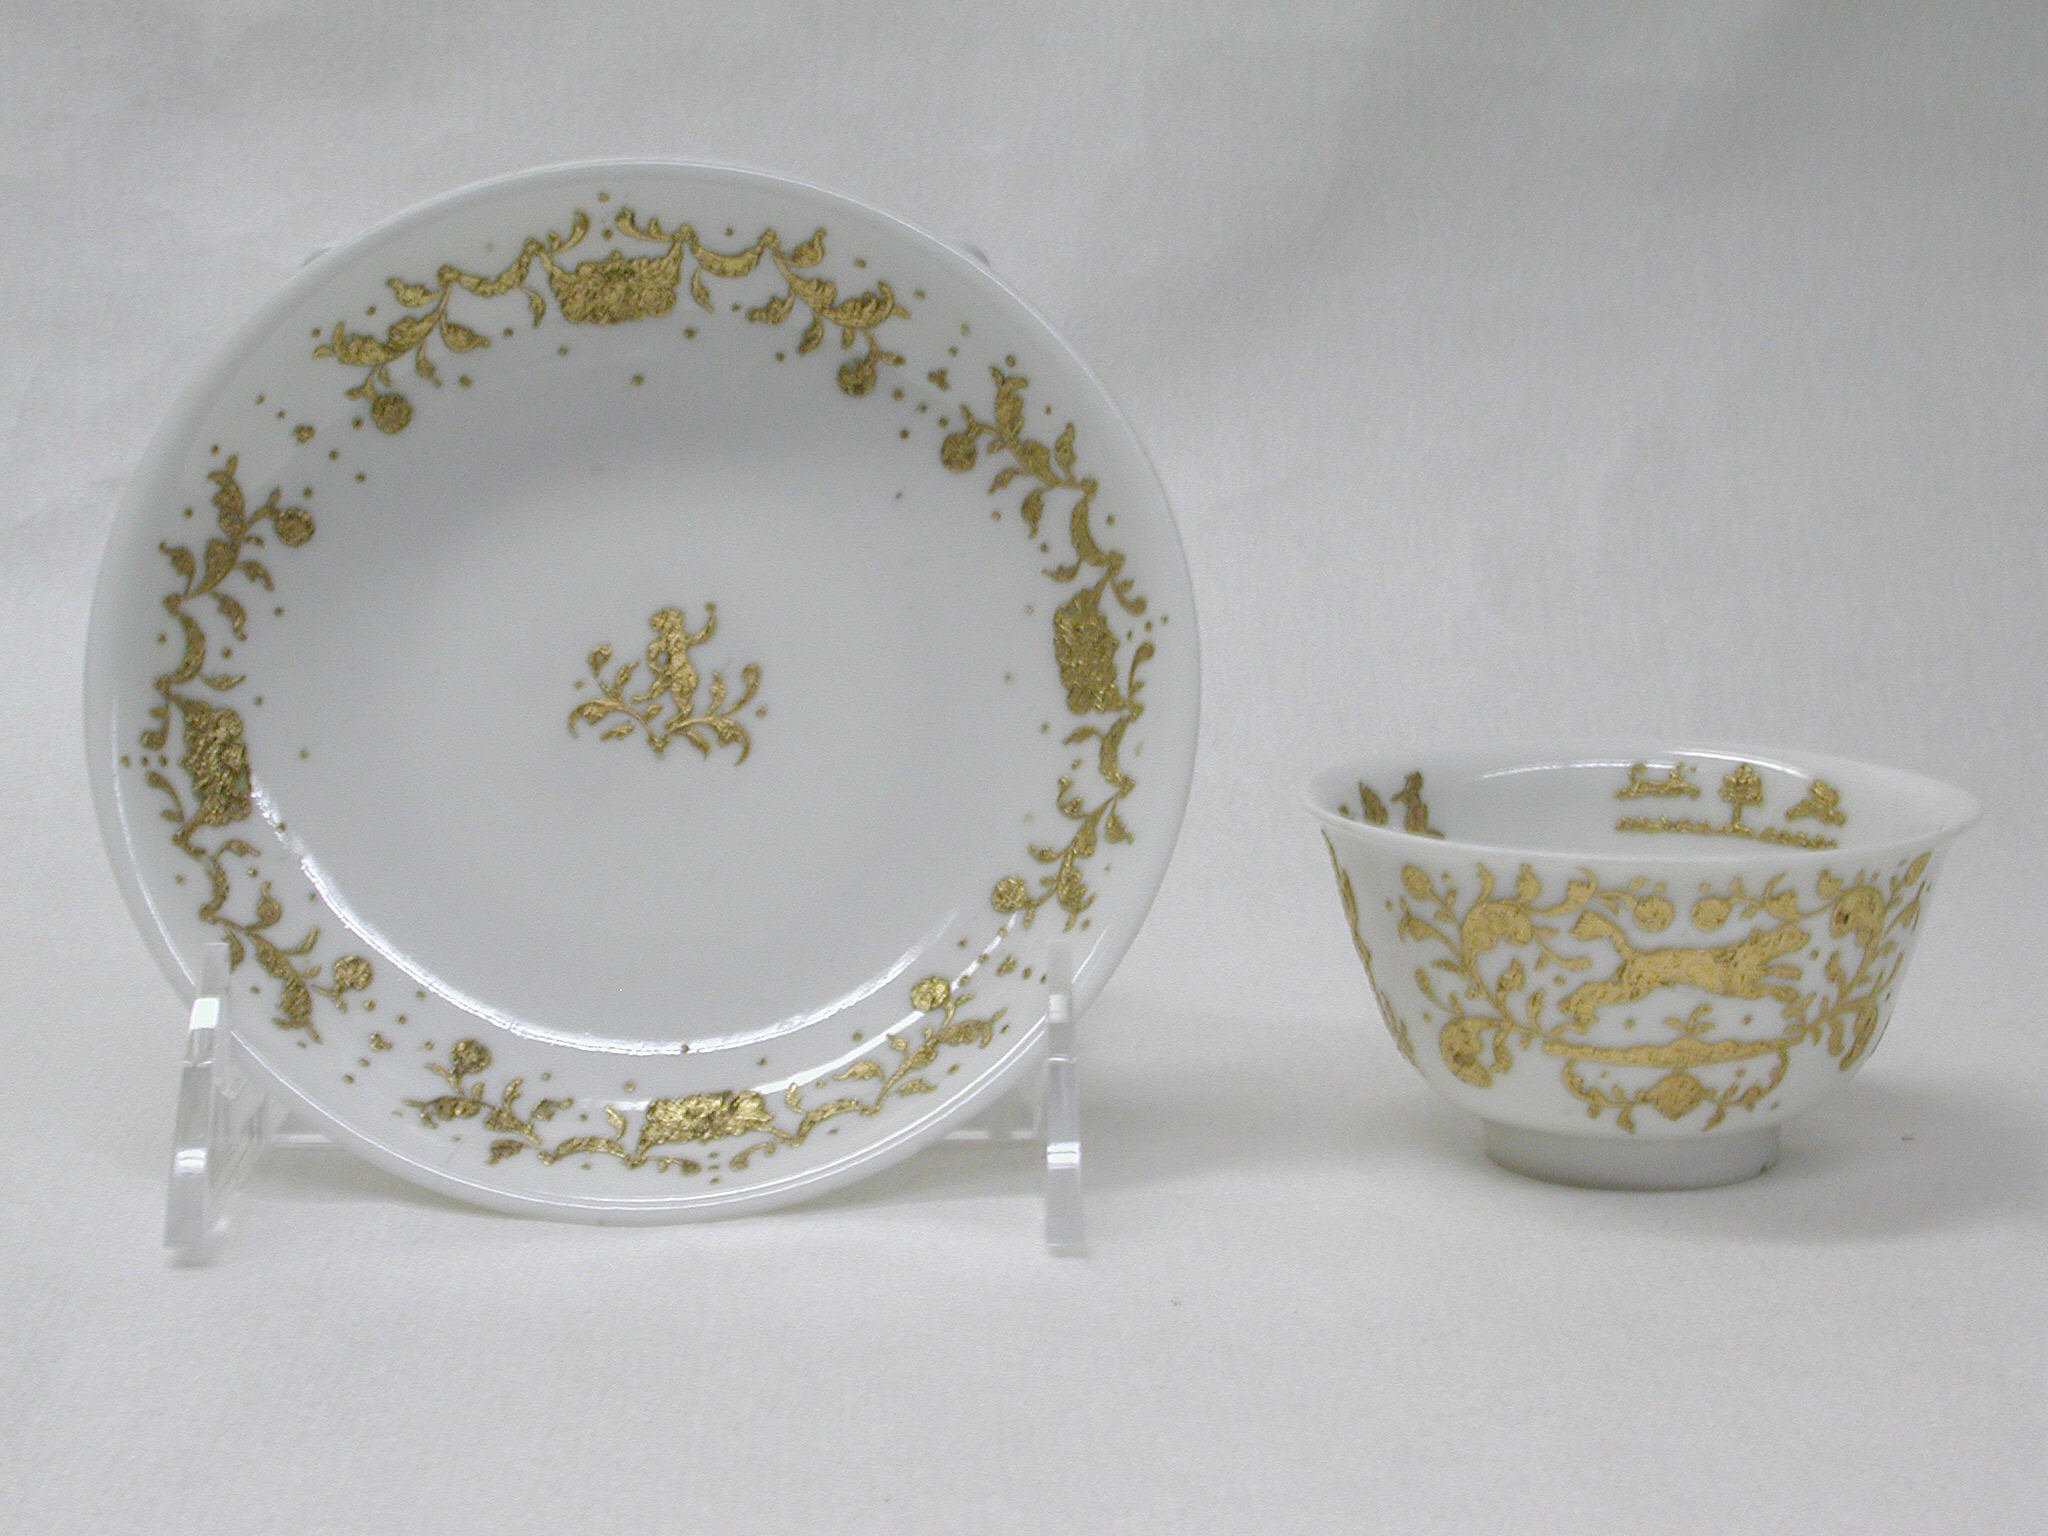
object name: teacup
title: Teacup (1 of 6) (part of a service)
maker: meissen manufactory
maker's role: manufactory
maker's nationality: german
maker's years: 1710-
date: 1720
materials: hard paste porcelain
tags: animals,flowers